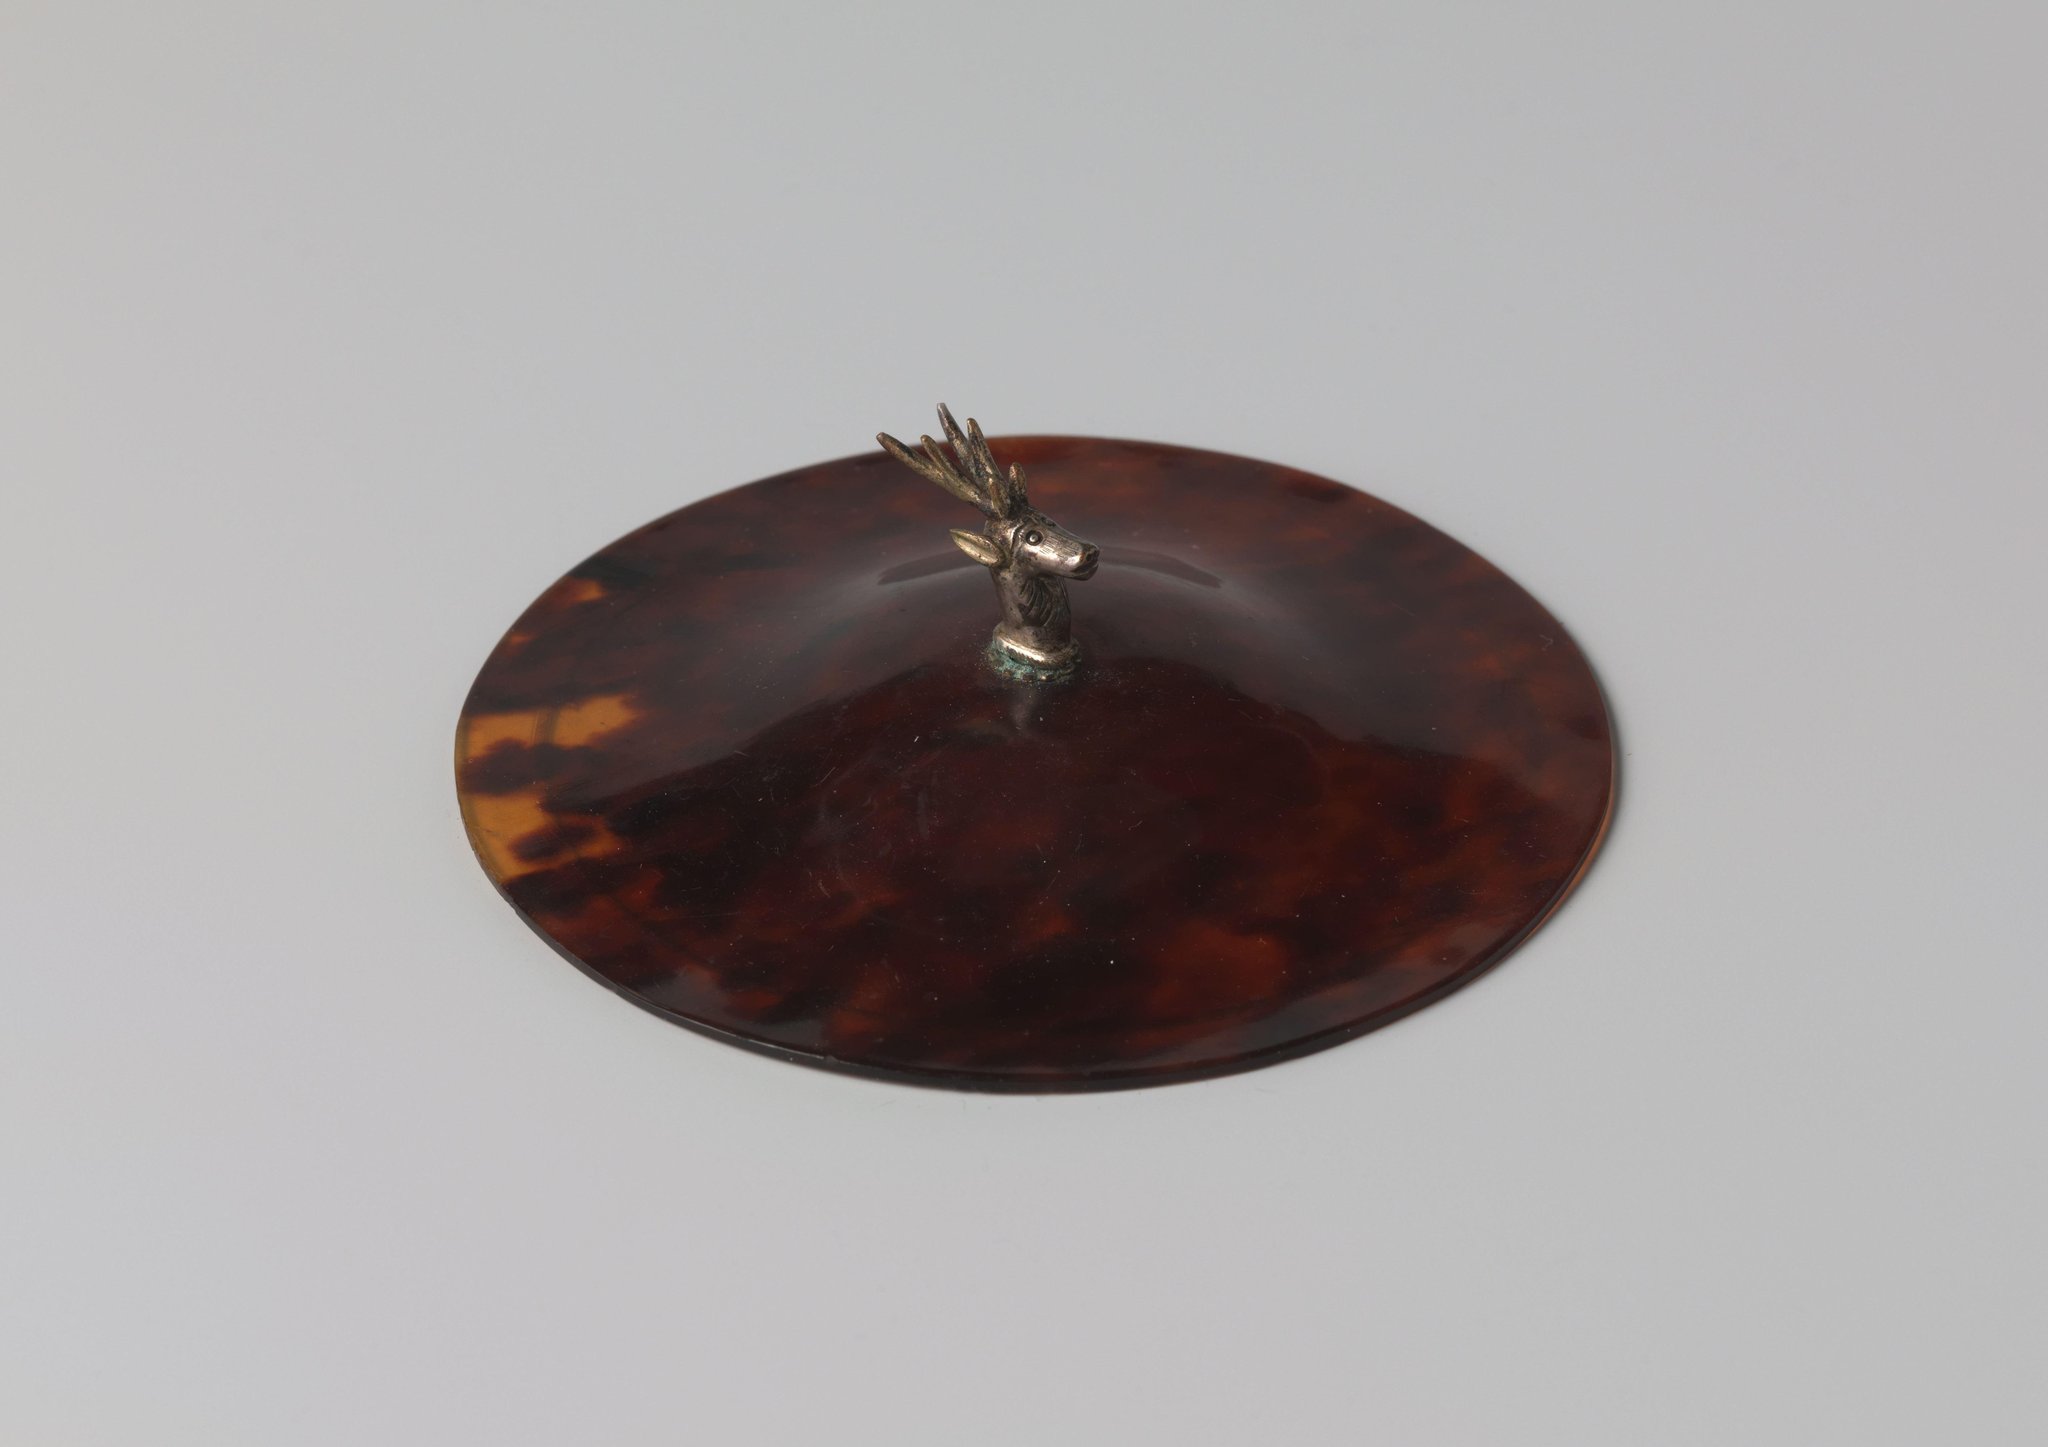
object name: lid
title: Deksel van schildpad met hertekop van zilver (serie van 28 stuks A t/m BB)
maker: Anonymous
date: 1700-1799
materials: silver, shell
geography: indonesia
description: Schildpad-deksel (28 stuks: A t/m BB) met hertekop van zilver als knop.